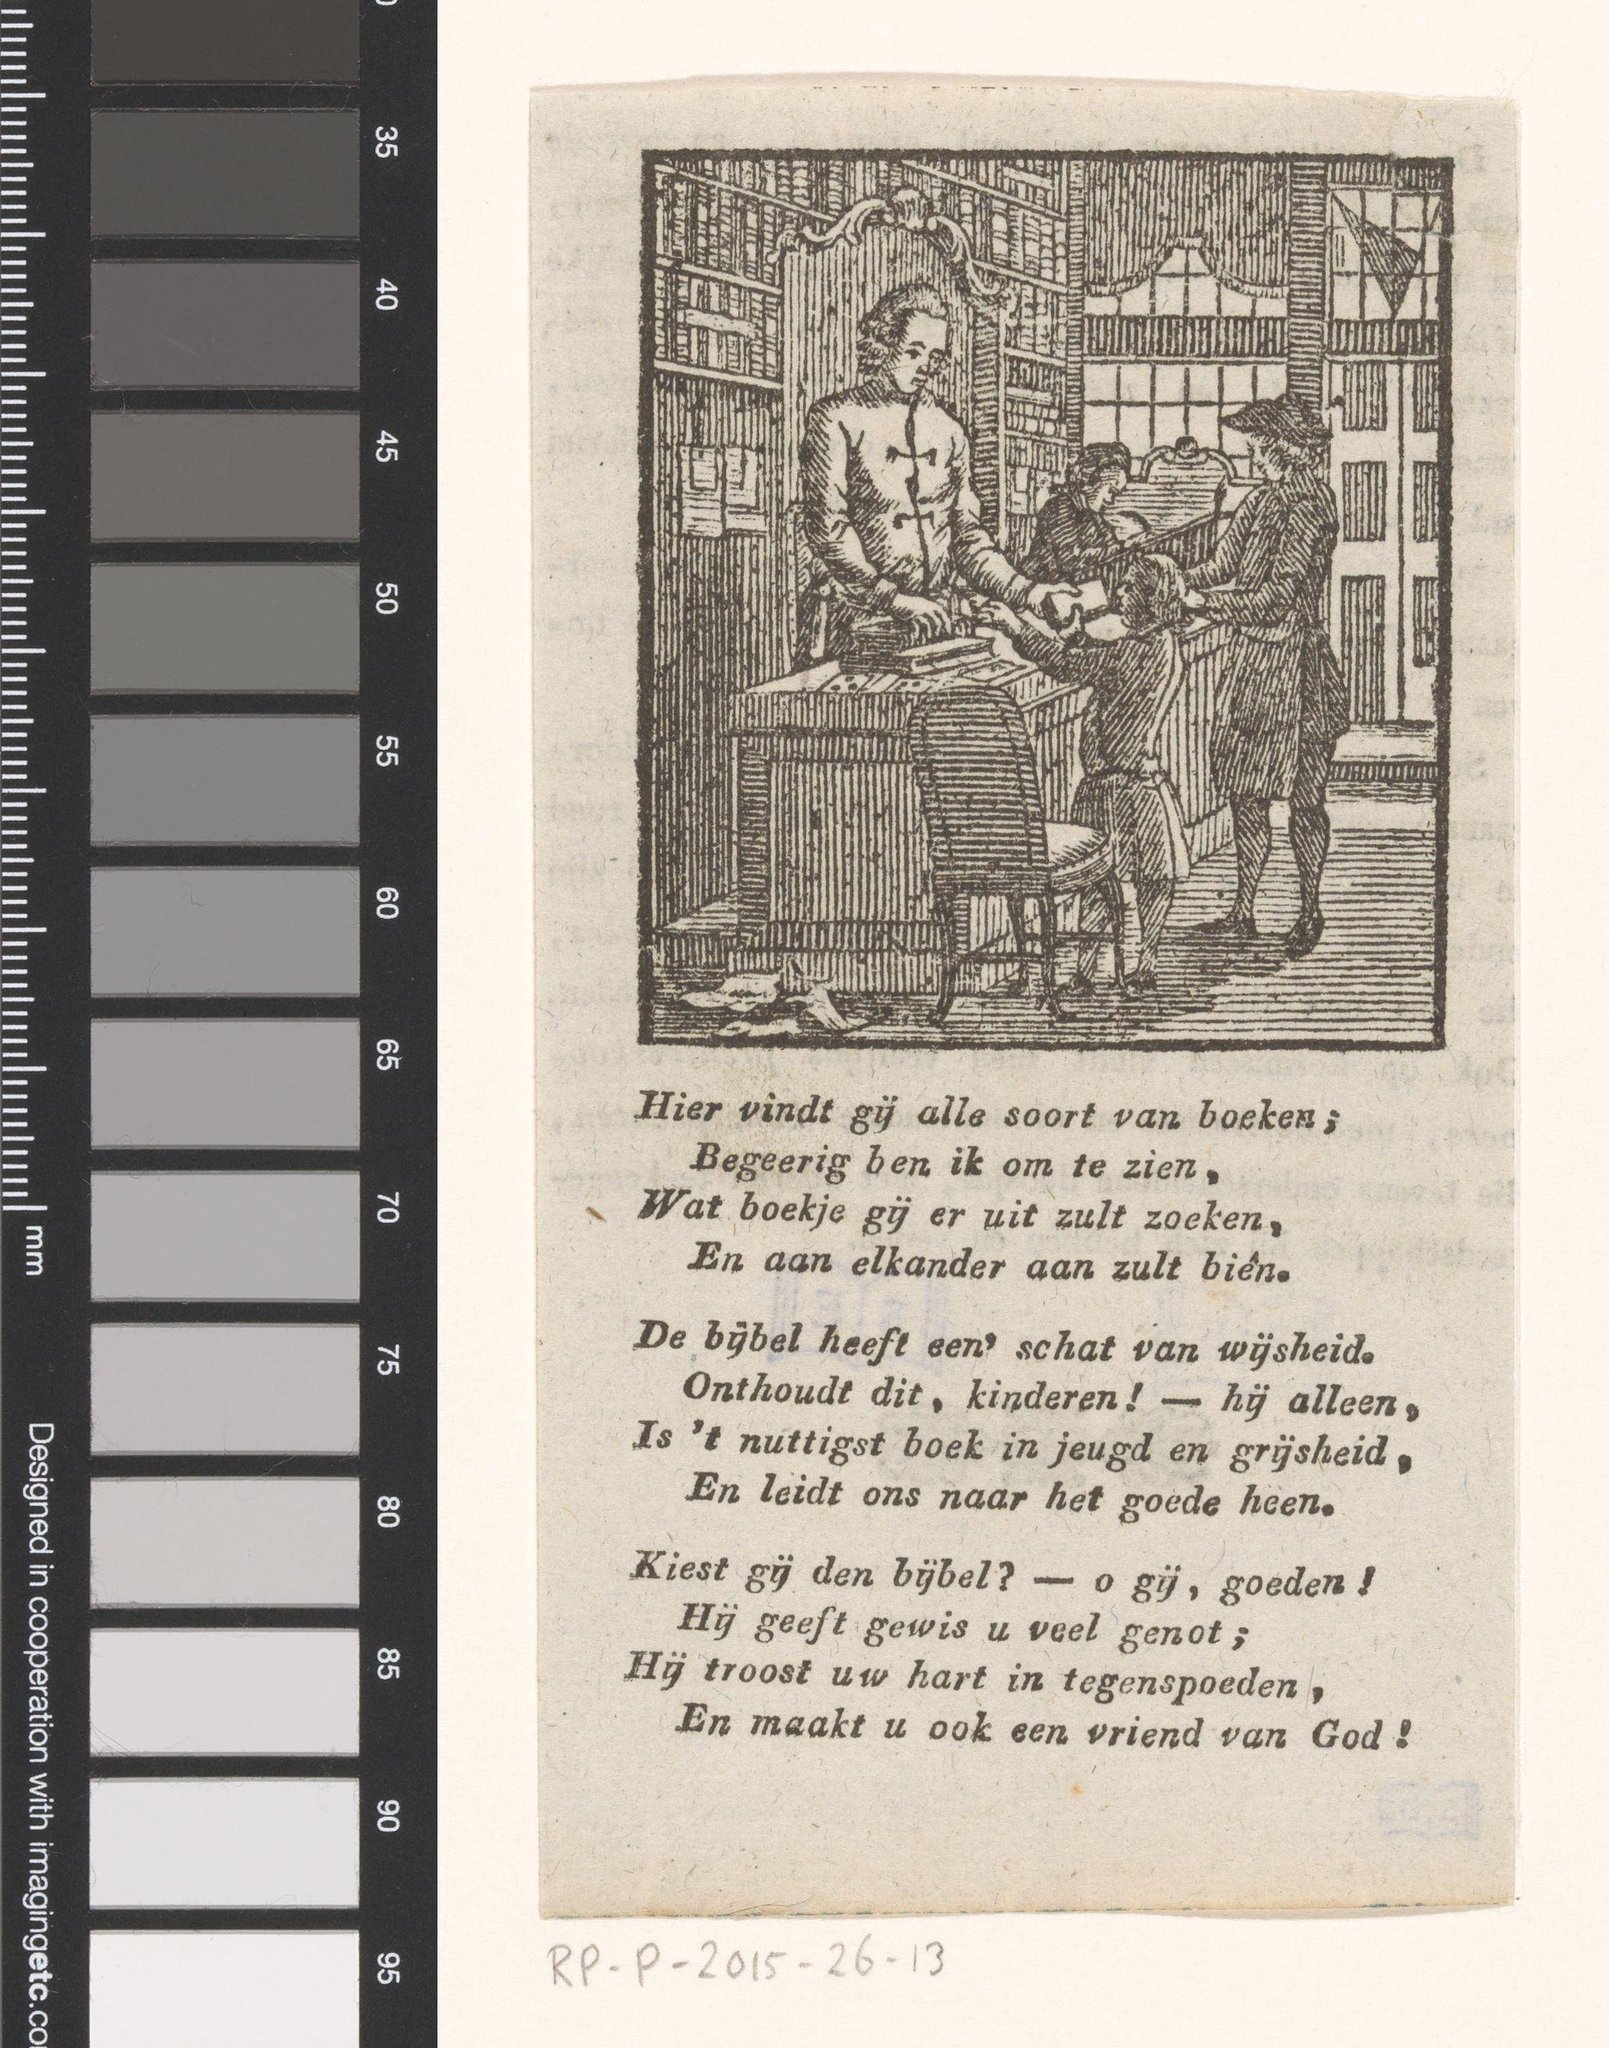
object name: book illustration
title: Jongen rekent een boek af in een boekwinkel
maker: Anonymous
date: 1800-1849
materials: paper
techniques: letterpress printing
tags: children's books, book-shop, bookseller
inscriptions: collector's mark: Lugt 4779, collector's mark: Lugt 2228, collector's mark: Lugt 4780